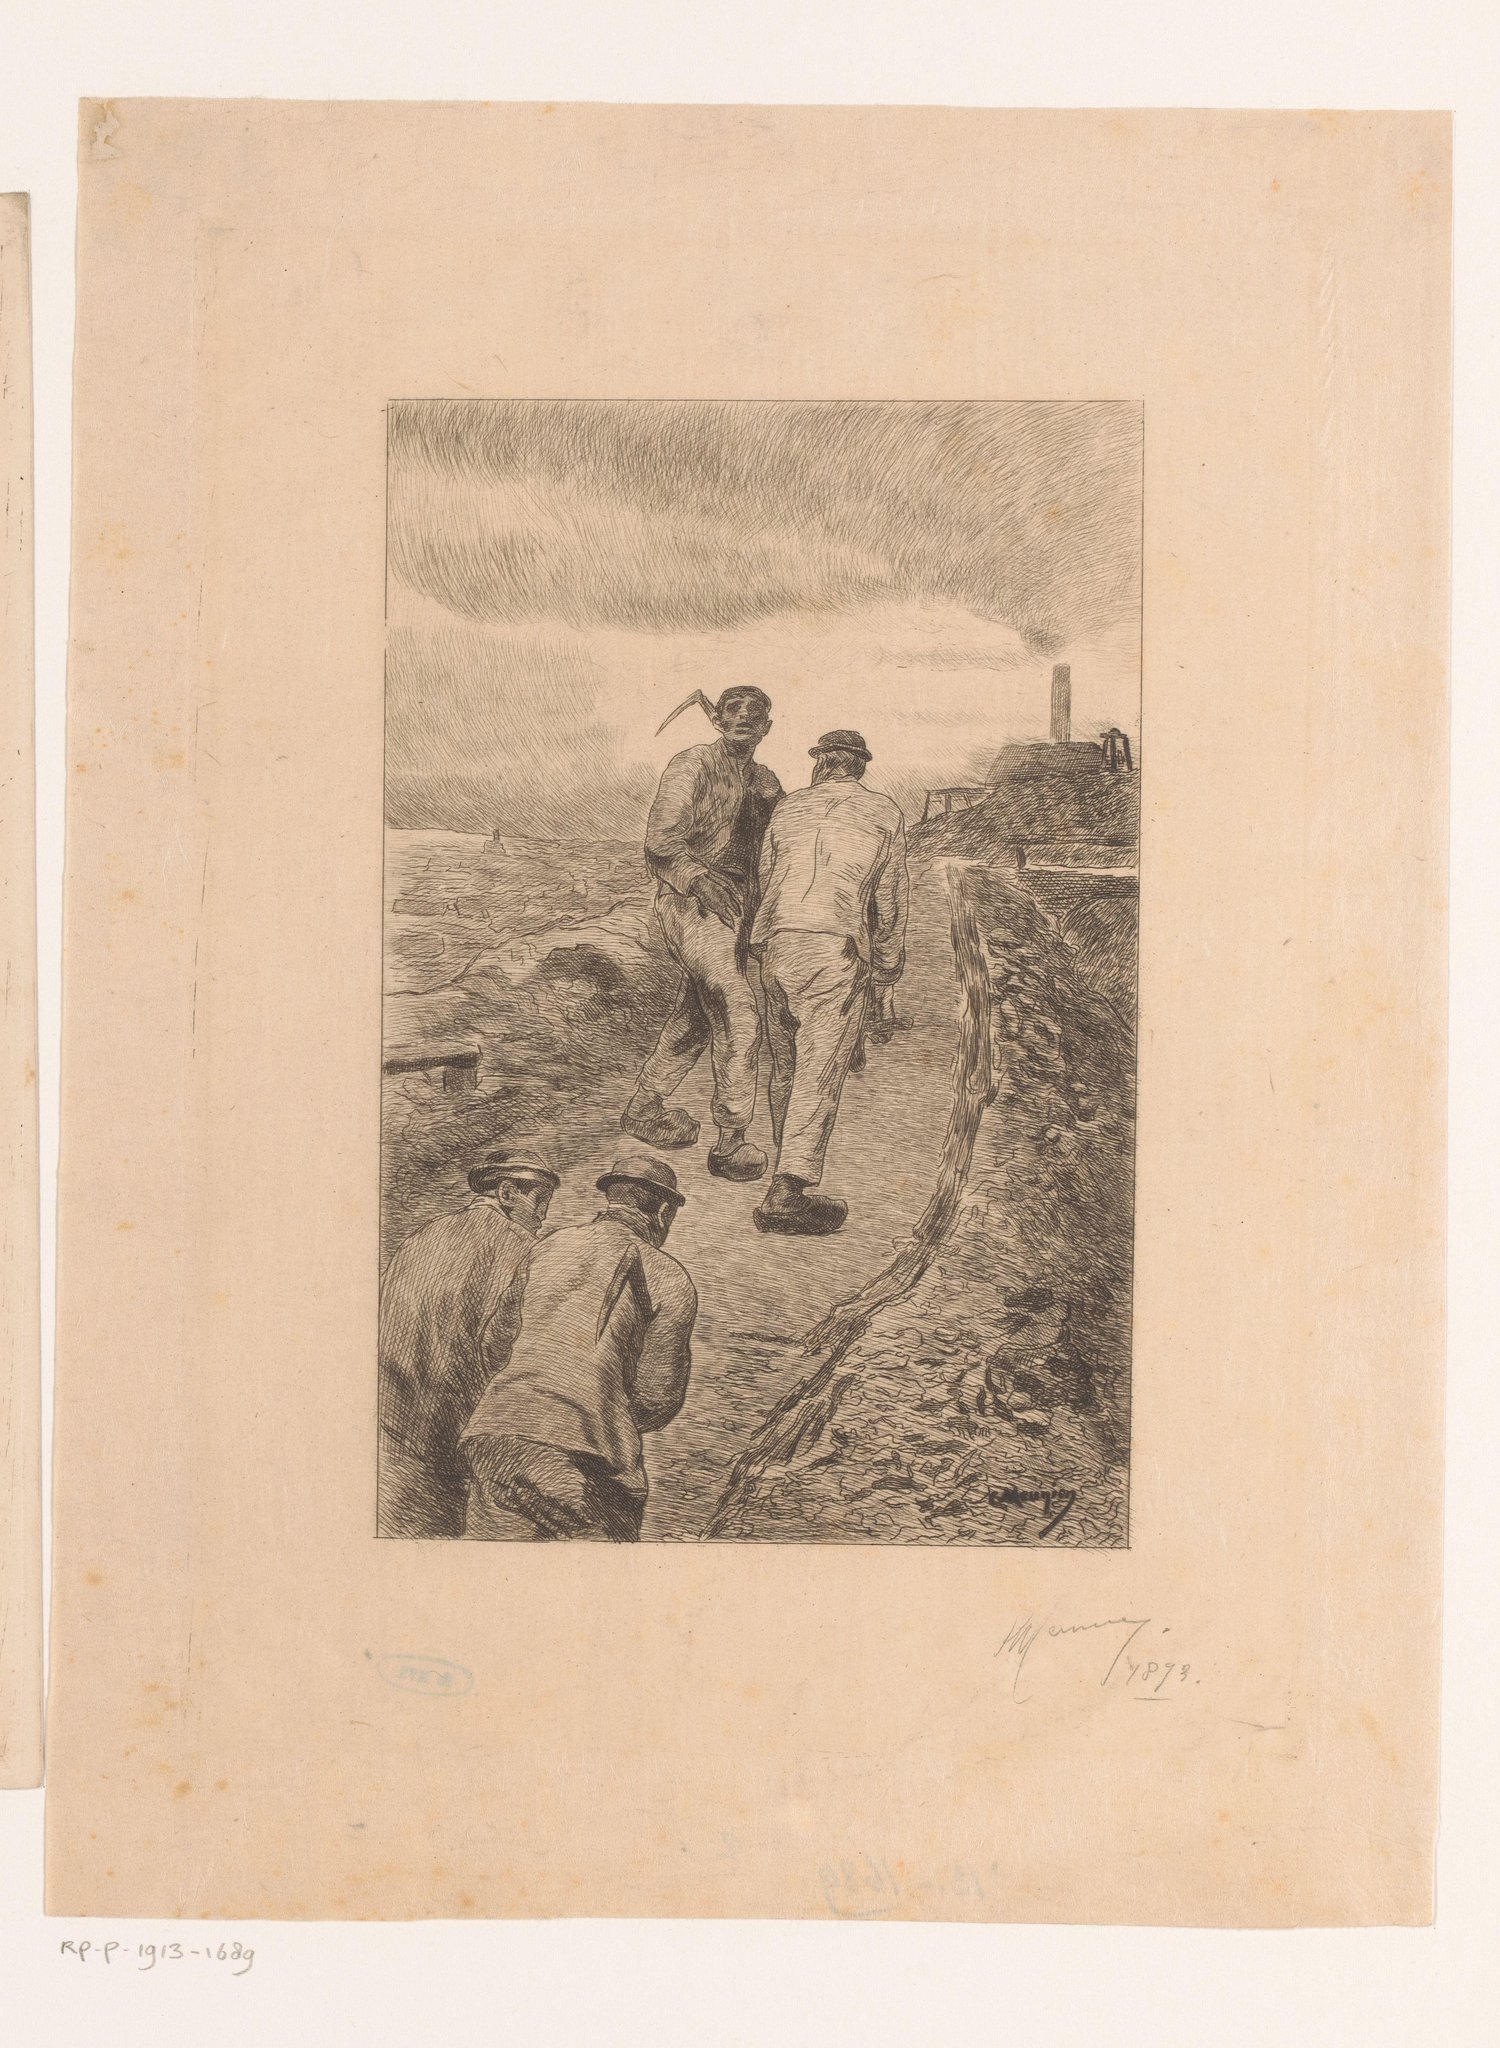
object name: print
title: Vier mijnwerkers op weg naar hun werk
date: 1893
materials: paper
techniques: drypoint, etching, intaglio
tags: miner, factory in landscape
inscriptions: collector's mark: Lugt 2228